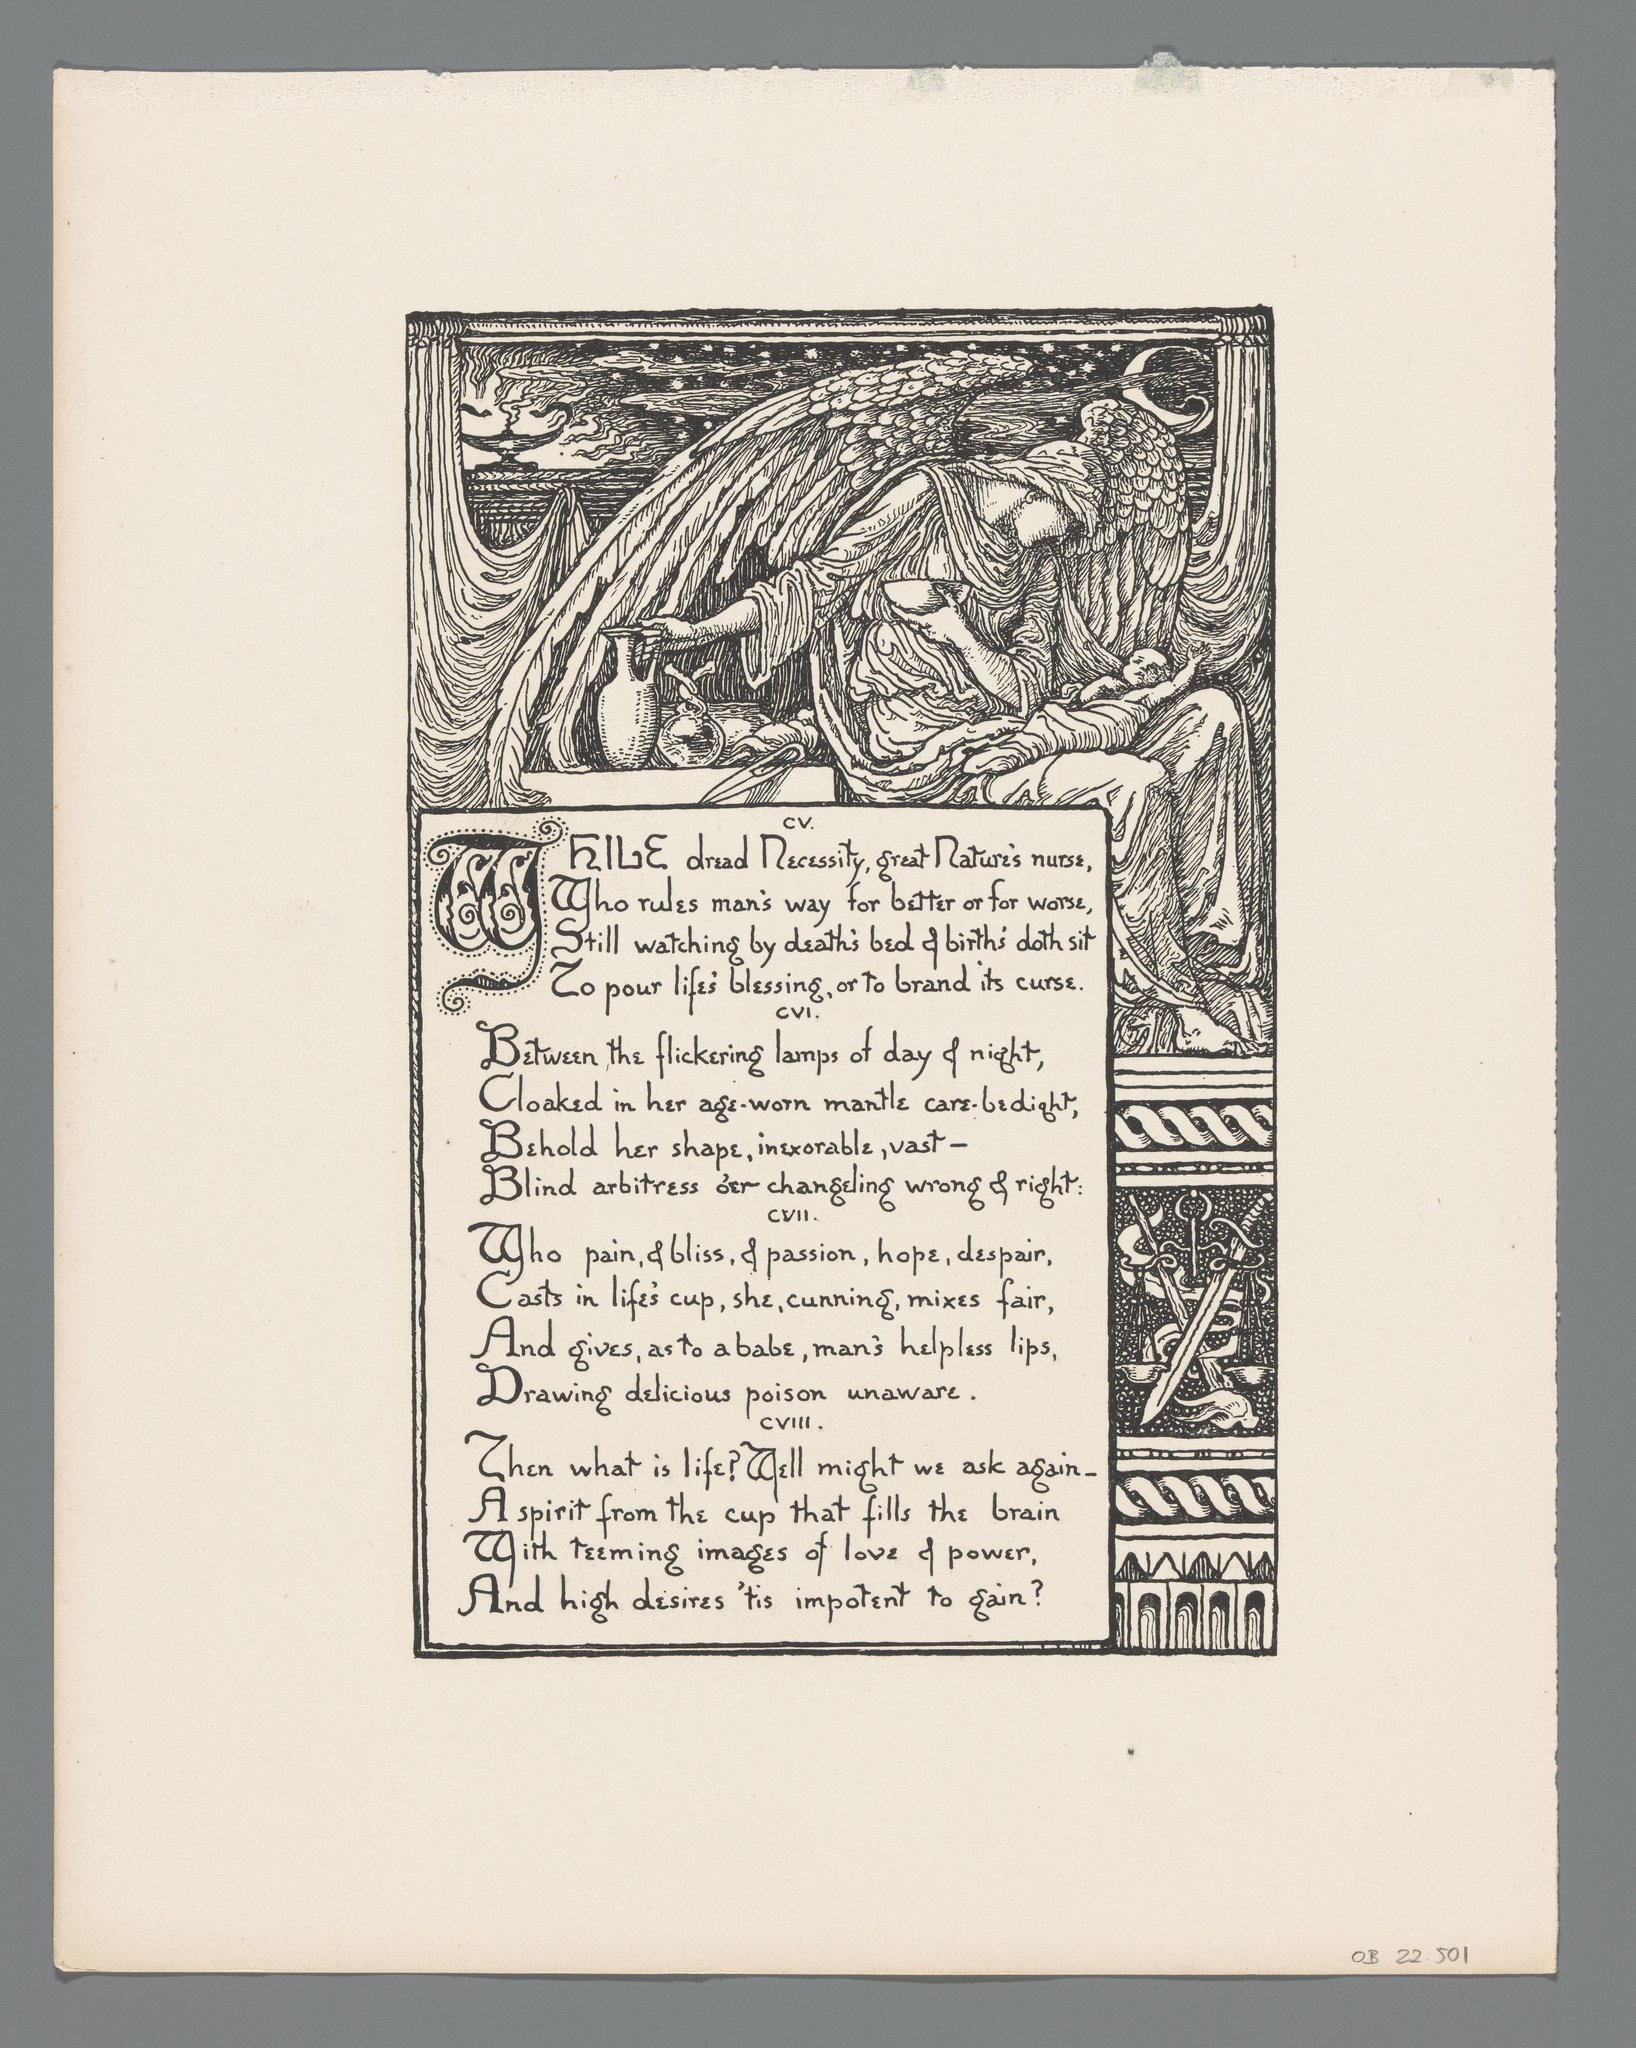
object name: print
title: Cartouche met baby op schoot bij een gevleugeld figuur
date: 1886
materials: paper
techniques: engraving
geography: london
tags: fabulous beings with wings, infant, baby, moon as celestial body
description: Prent uit: Crane, Walter. The sirens three. Londen: Macmillan & Co., 1886.